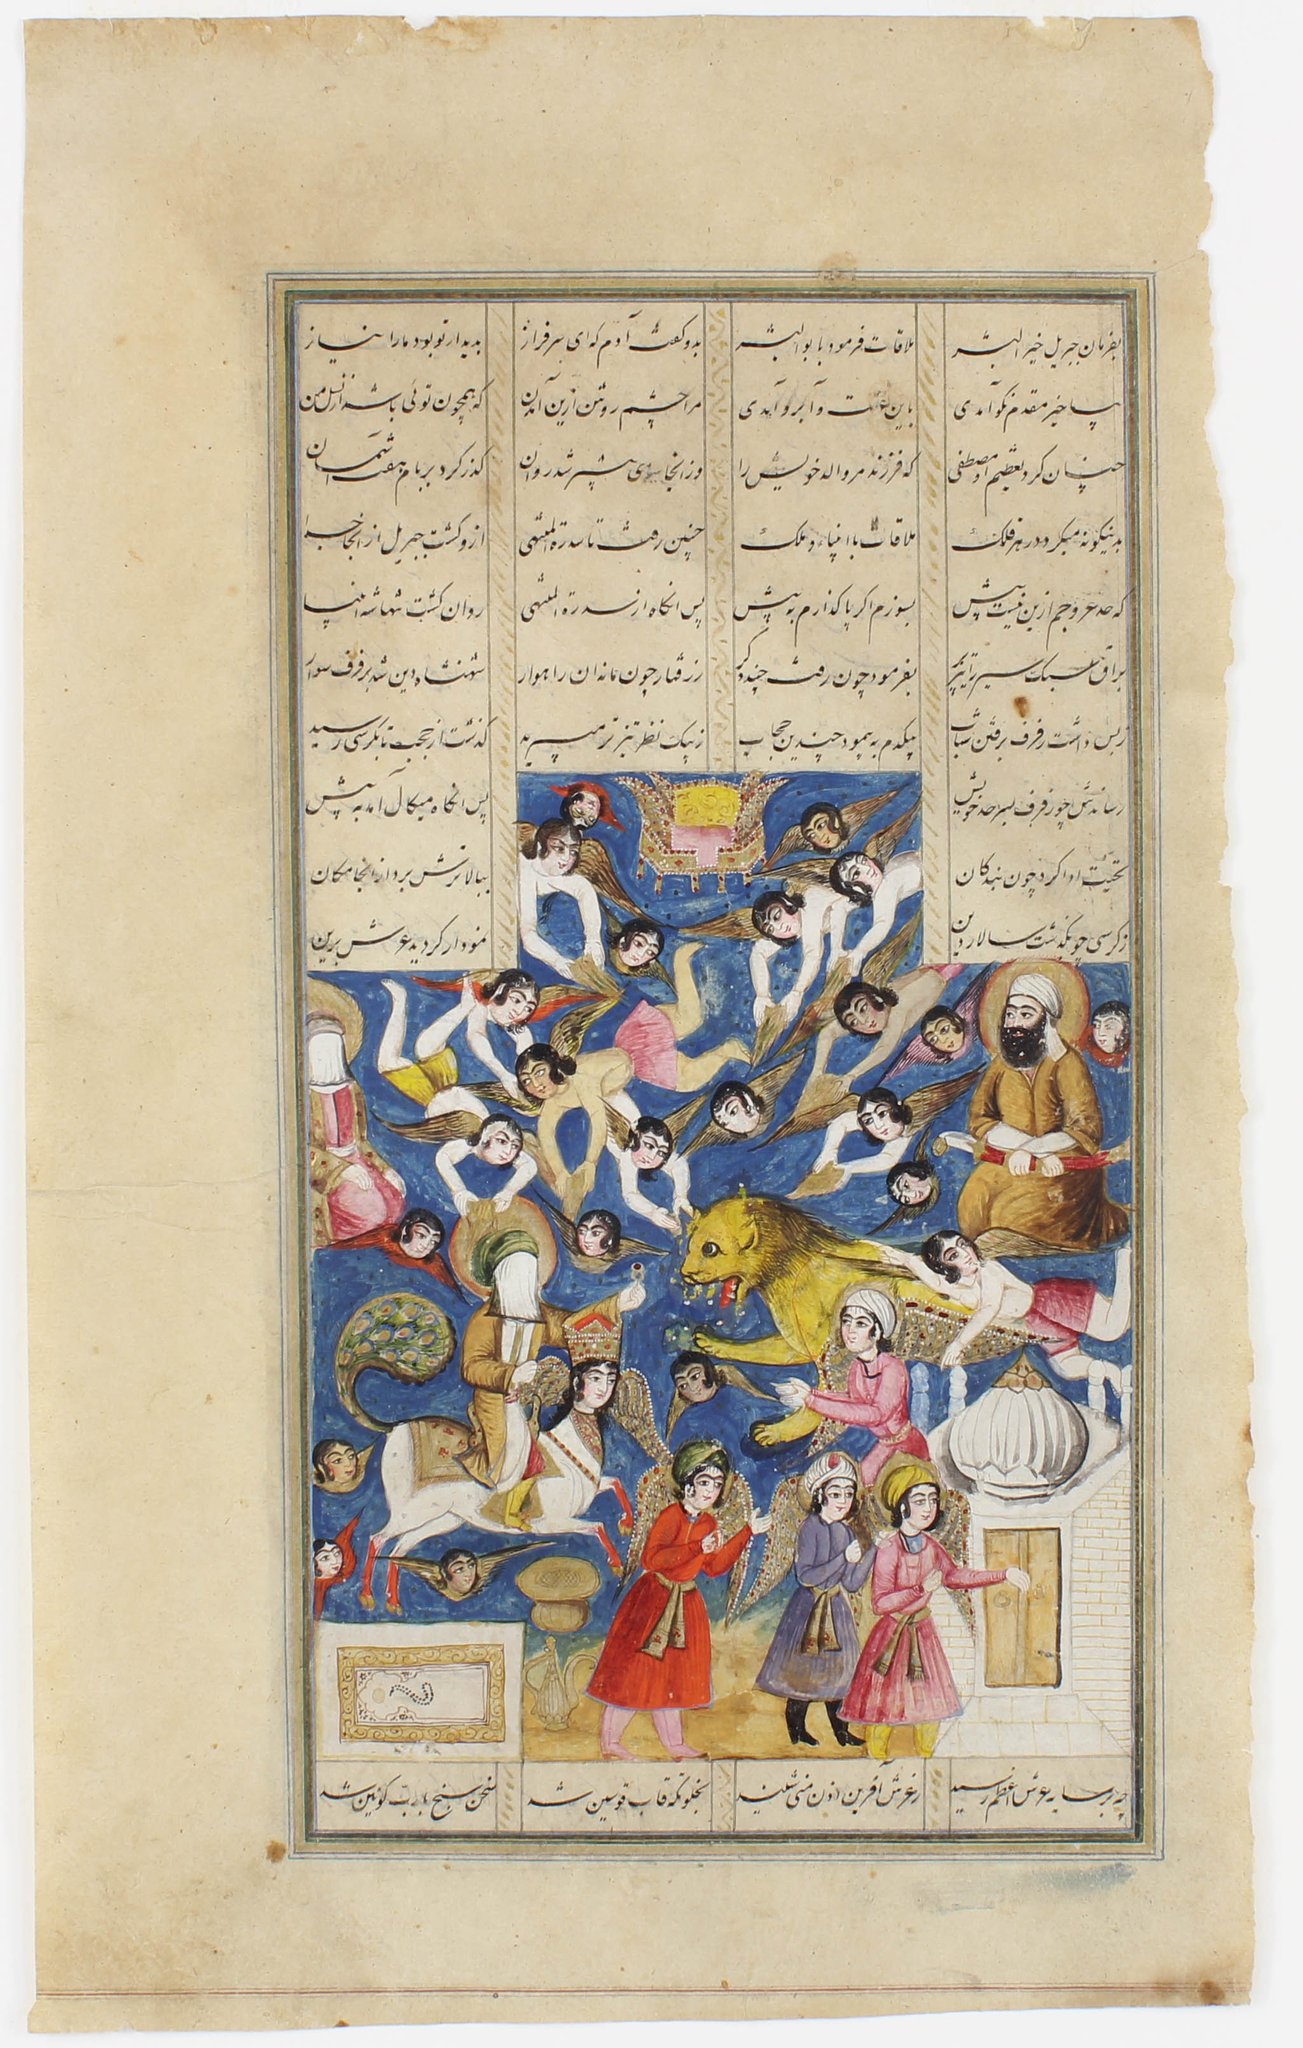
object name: folio from an illustrated manuscript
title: "Mi'raj, The Night Journey of the Prophet," Folio from a Hamla-yi Haidari (Attack of the Lion)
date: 1801-1900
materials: gold, ink, paper, silver, watercolor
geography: iran